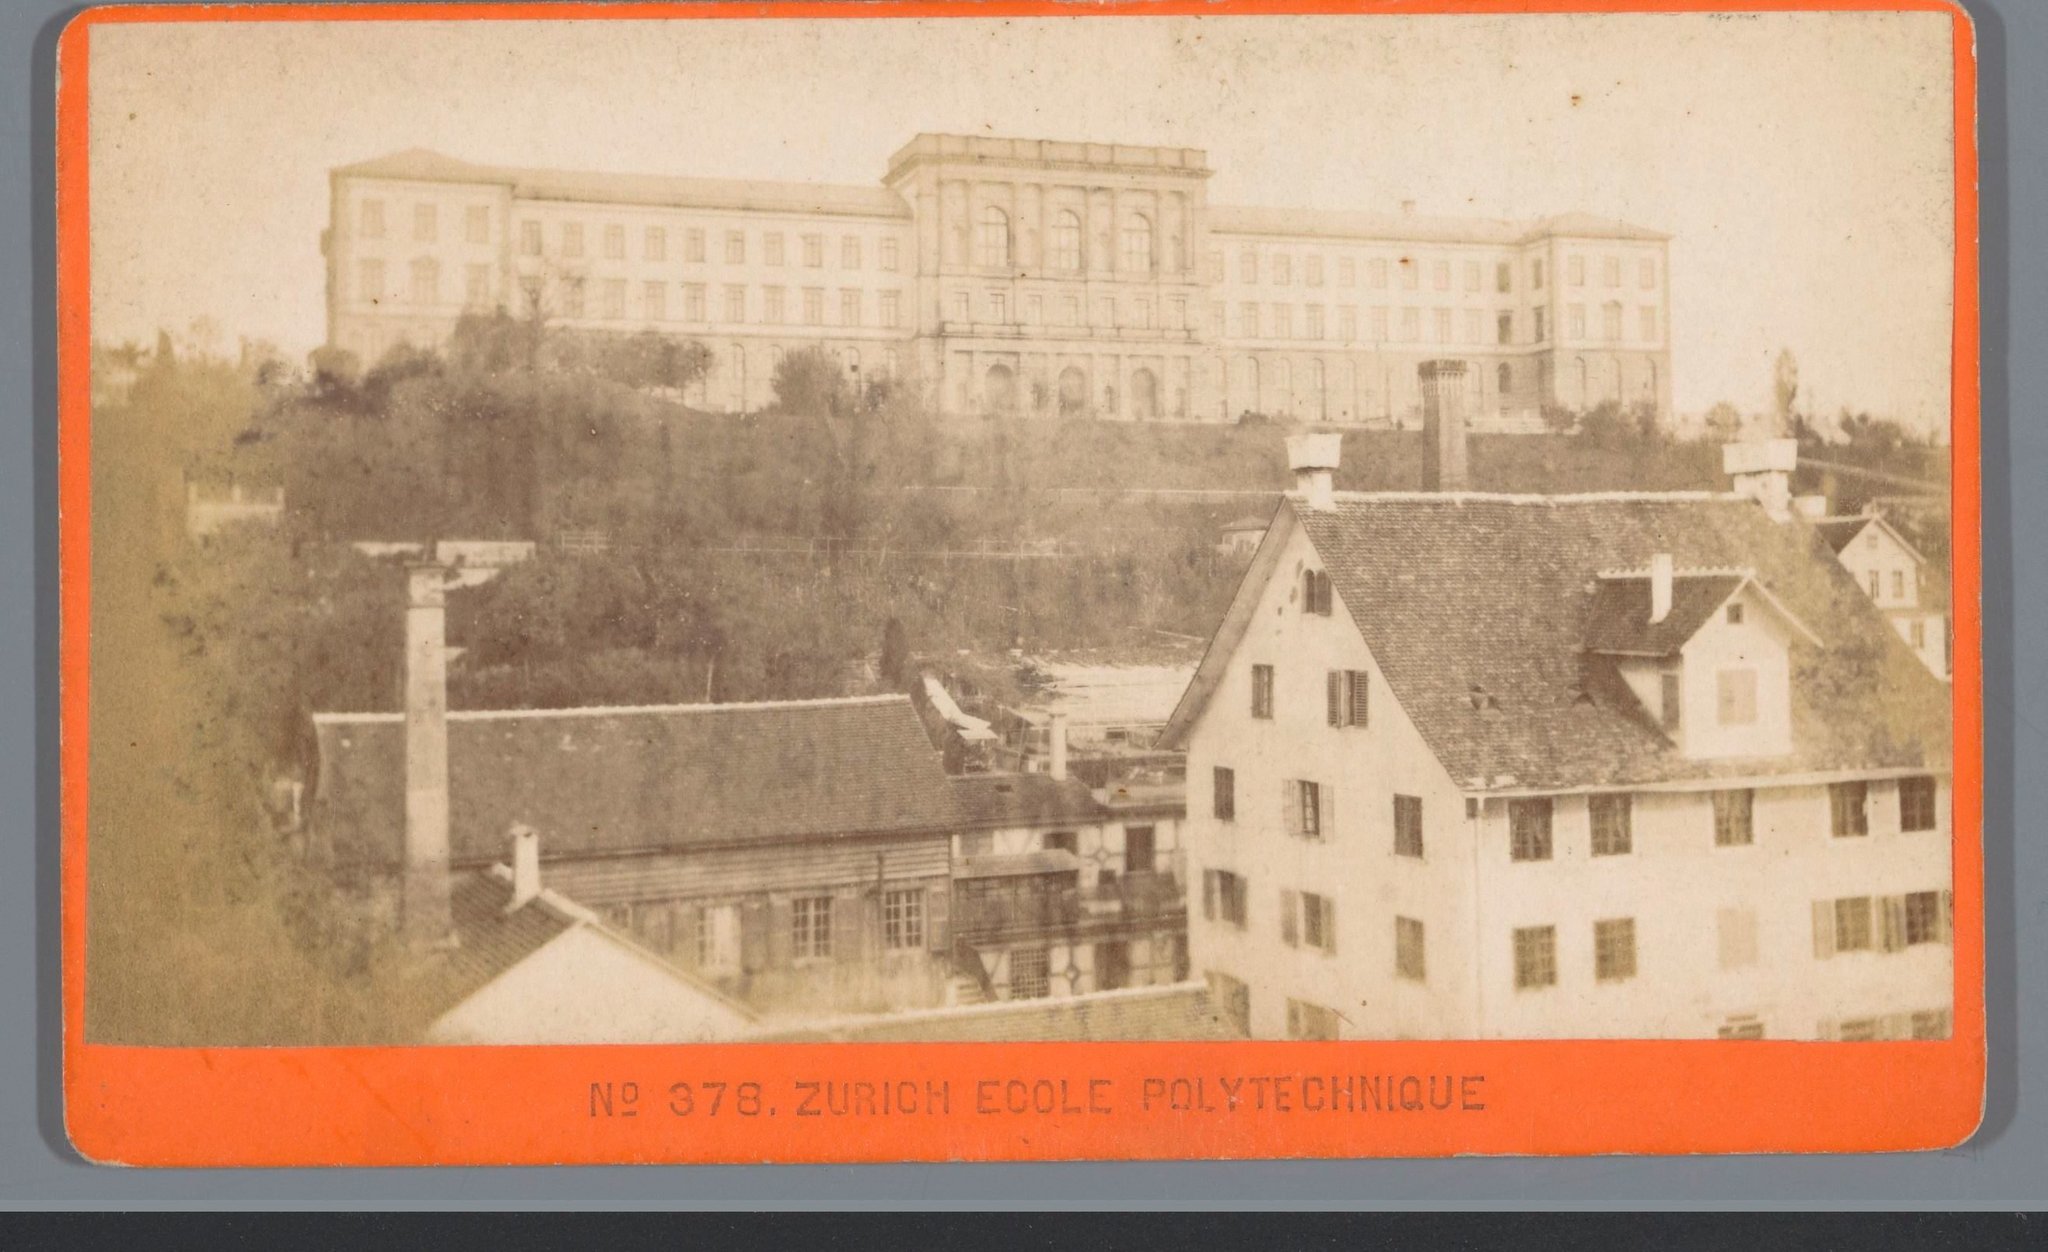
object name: photograph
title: Eidgenössische Technische Hochschule, Zürich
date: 1870-1883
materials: cardboard, paper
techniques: albumen print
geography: zurich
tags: city-view in general; 'veduta'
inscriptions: number: ‘No 378.’, inscription: ‘No................./ MAISON DES TROIS ROIS’